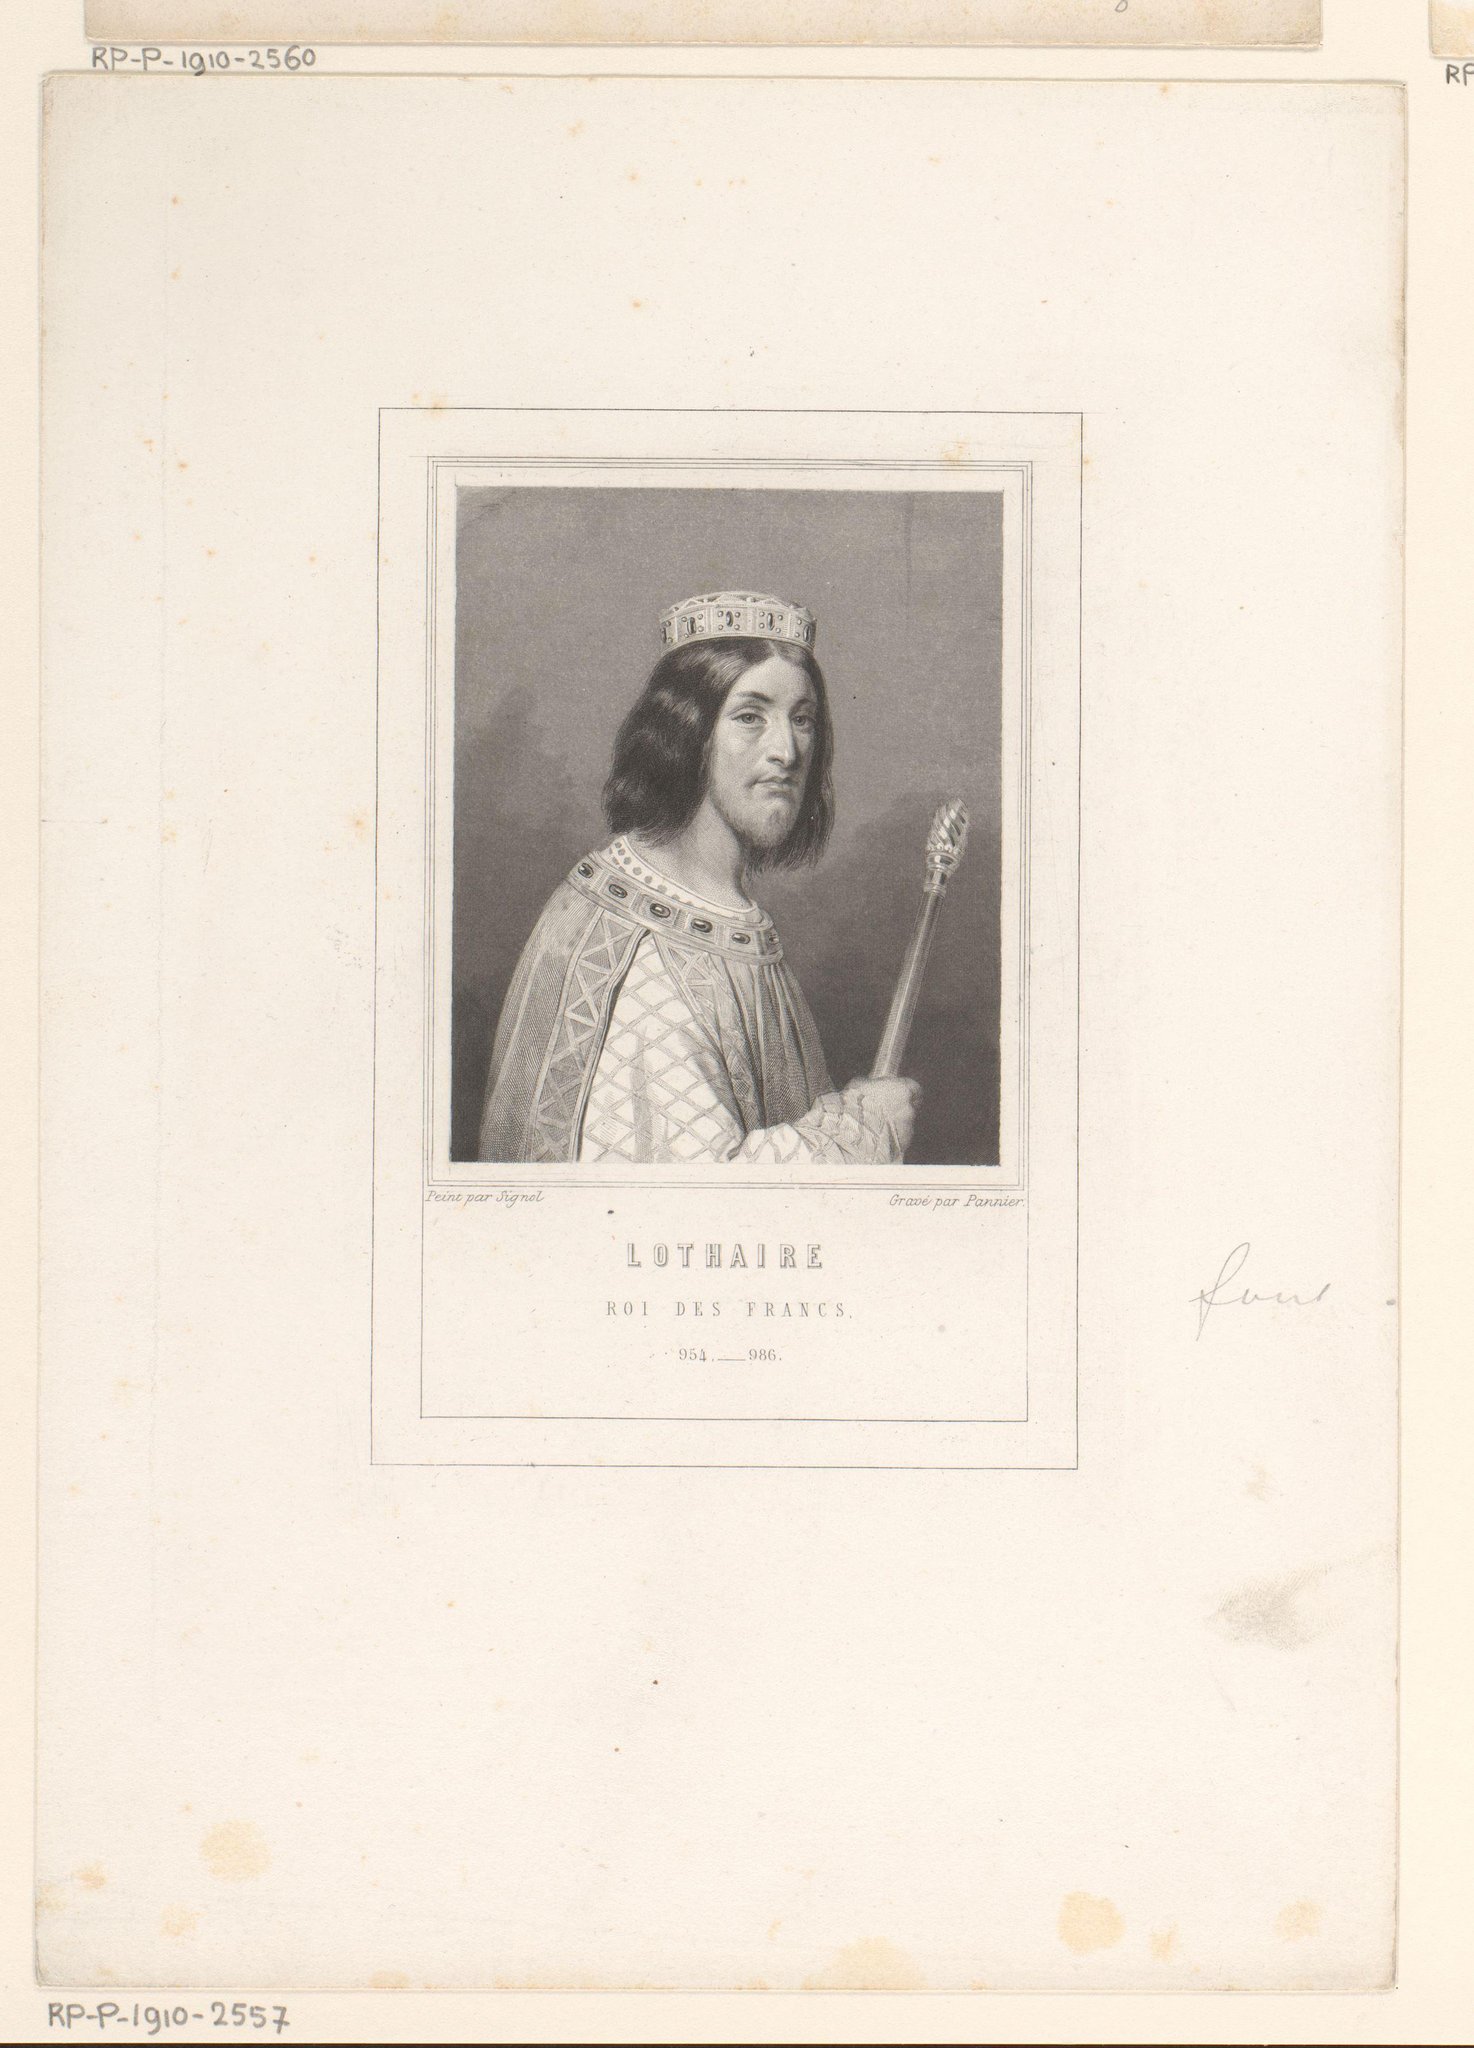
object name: print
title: Lothaire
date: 1812-1869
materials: paper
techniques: engraving, etching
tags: historical persons, king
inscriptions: collector's mark: Lugt 2228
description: Portret is hetzelfde als op RP-P-1910-2556.